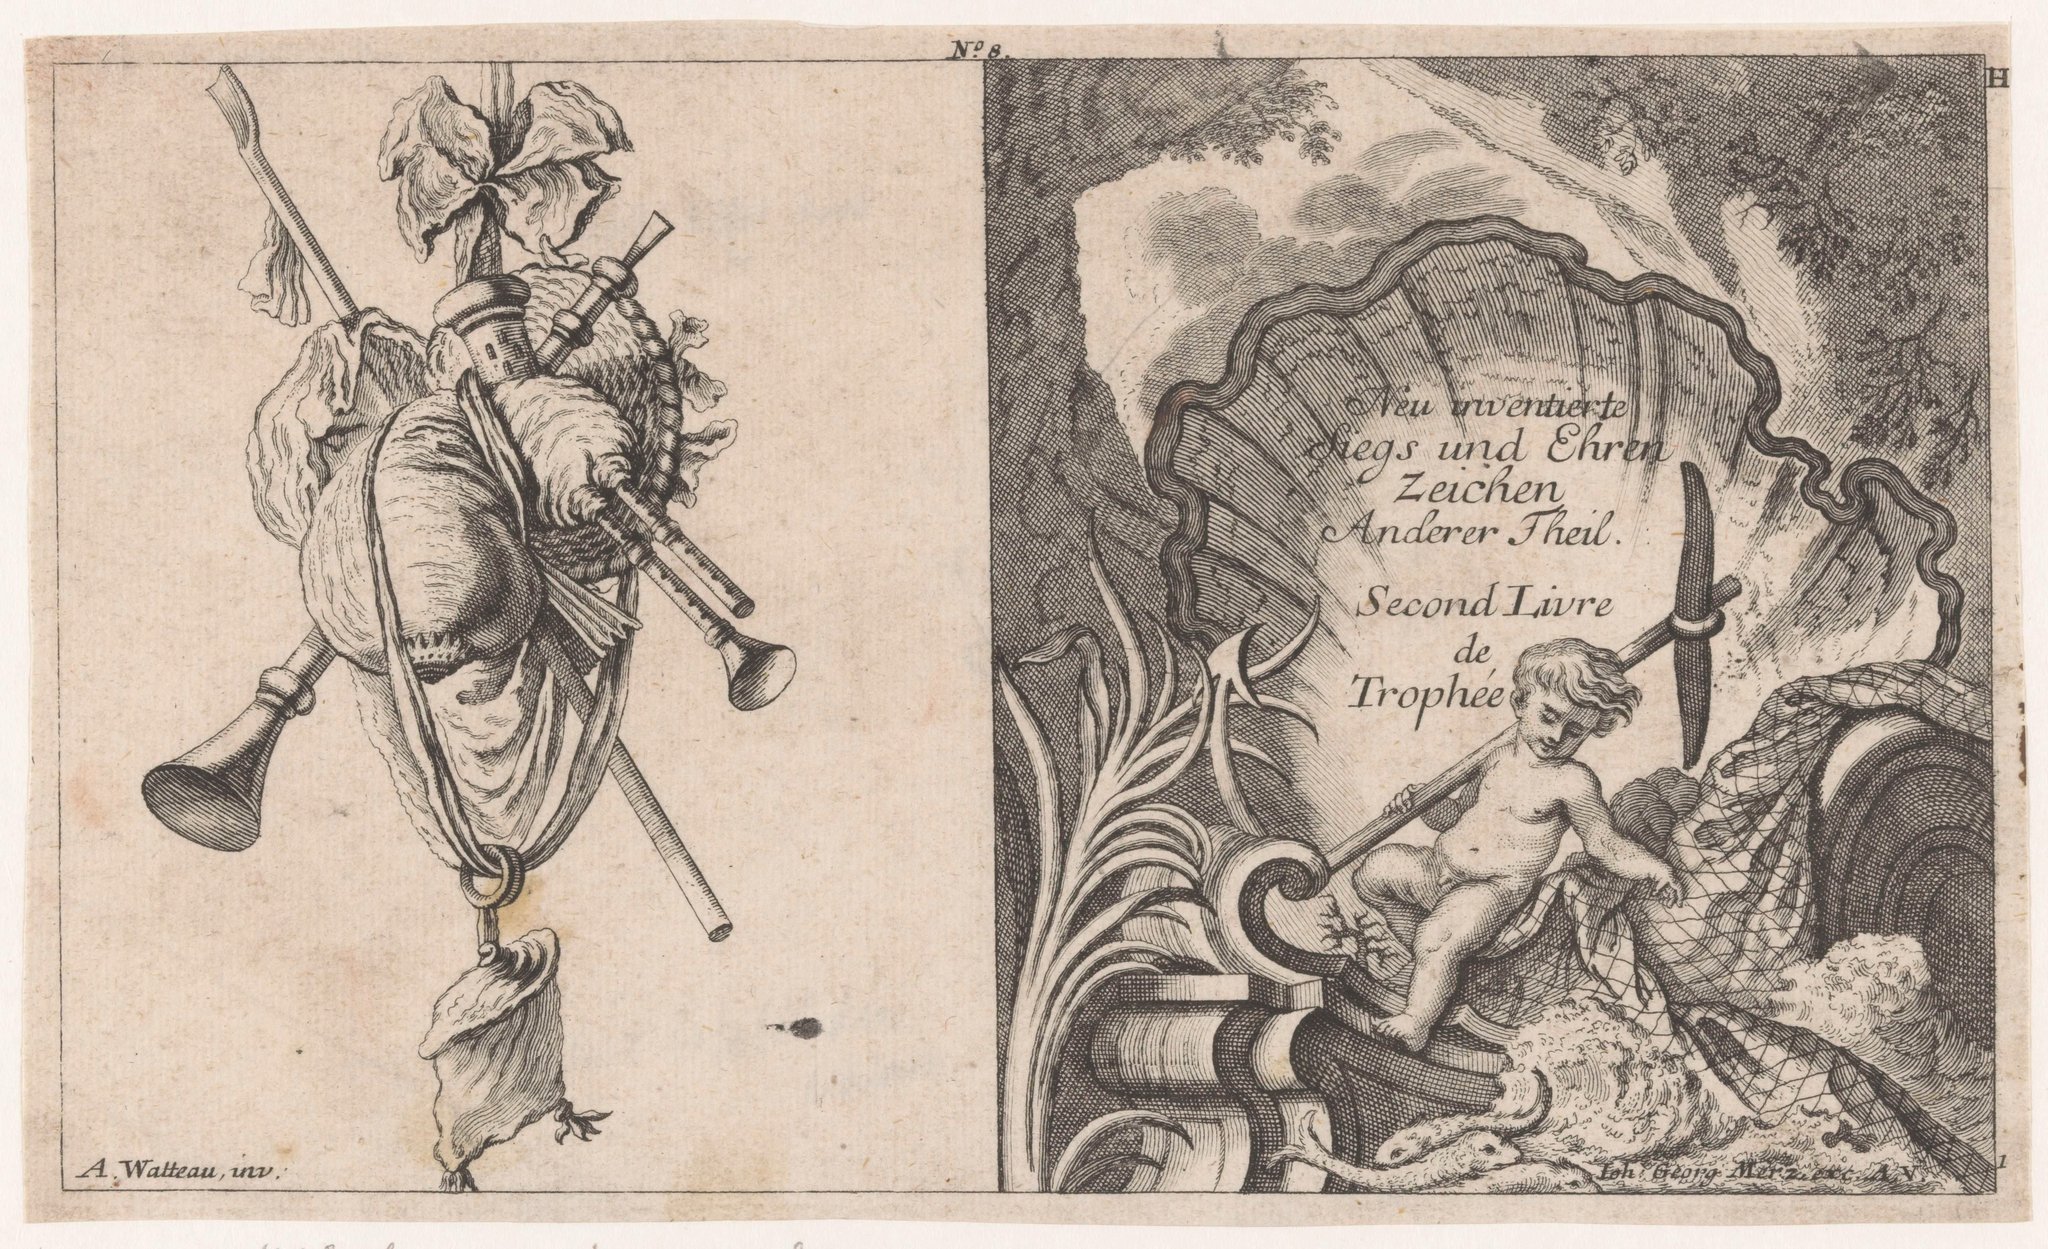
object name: print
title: Trofee met doedelzak en putto zittend voor een schelp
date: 1704-1762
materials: paper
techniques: engraving, etching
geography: augsburg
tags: trophy, i.e.: decorative arrangement of symbolic or typical objects ~ ornament, bagpipe, musette, scallop, shell ~ ornament, cupids: 'amores', 'amoretti', 'putti'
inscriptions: collector's mark: Lugt 2228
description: Links een trofee met een doedelzak, fluiten, een tas en een herdersstaf. Rechts zit een putto op een ornament met water en vissen, achter hem een schelp met de serietitel. Uitgeversnummer 8. Rechts boven H genummerd.